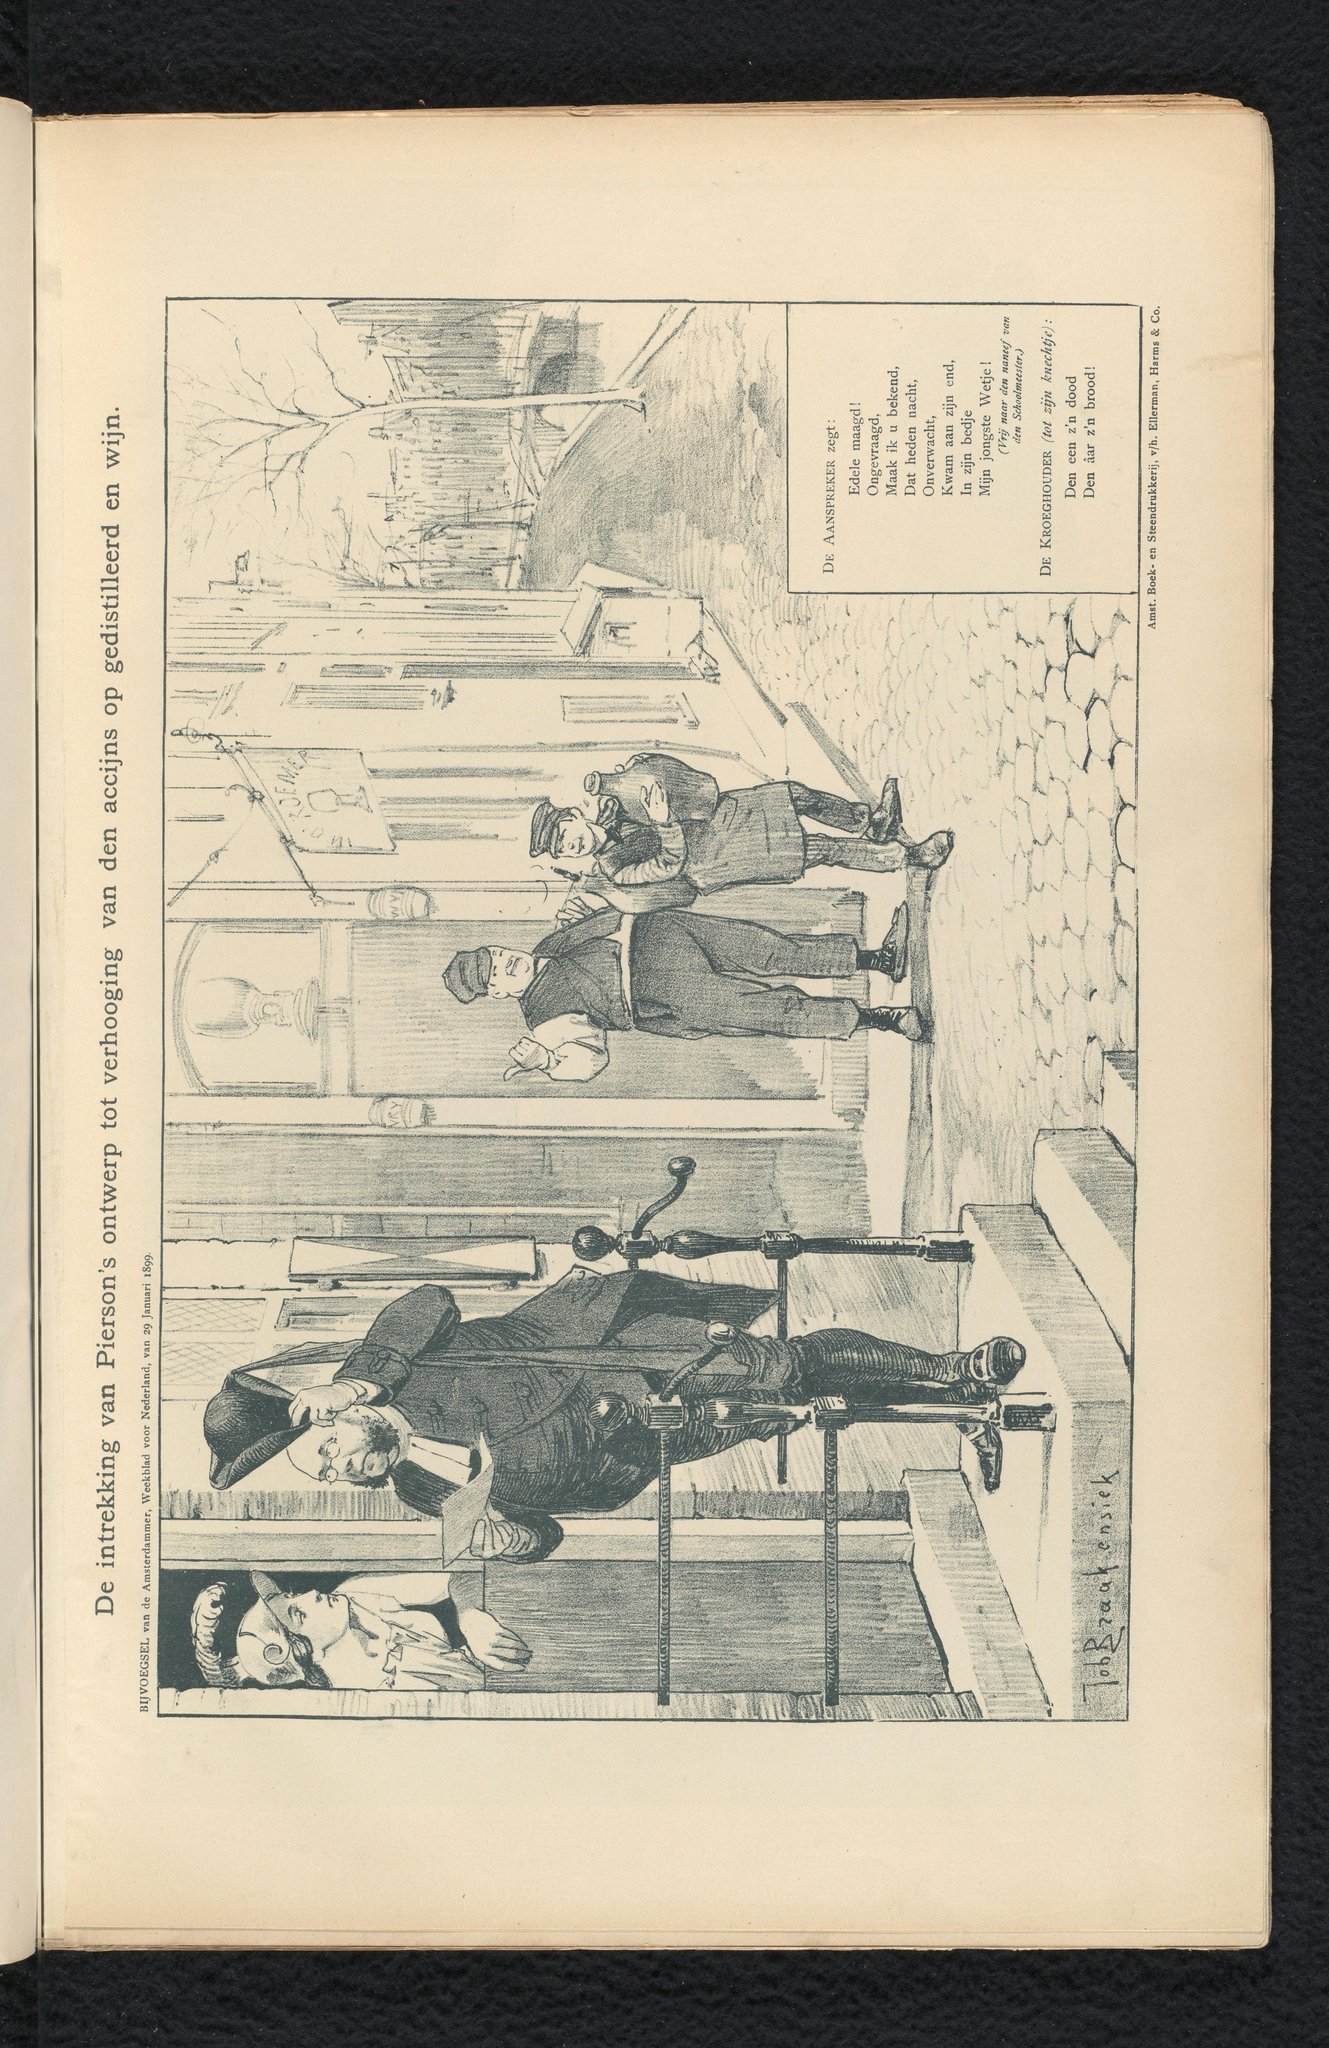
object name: cartoon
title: De intrekking van Pierson's ontwerp tot verhooging van den accijns op gedistilleerd en wijn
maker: johan braakensiek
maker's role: draughtsman, print maker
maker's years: 1858-1940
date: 1899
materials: paper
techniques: lithograph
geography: netherlands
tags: amsterdam, politician, nicolaas gerard pierson, oral announcement (of death), undertaker's man, personifications of countries, nations, states, districts, etc., inn, coffee-house, public house, etc., alcoholic drinks, political caricatures and satires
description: Premier Pierson als aanspreker aan de deur bij de Nederlandse Maagd om de dood van zijn wet bekend te maken, op de achtergrond is een kroegbaas blij met het intrekken van de wet.